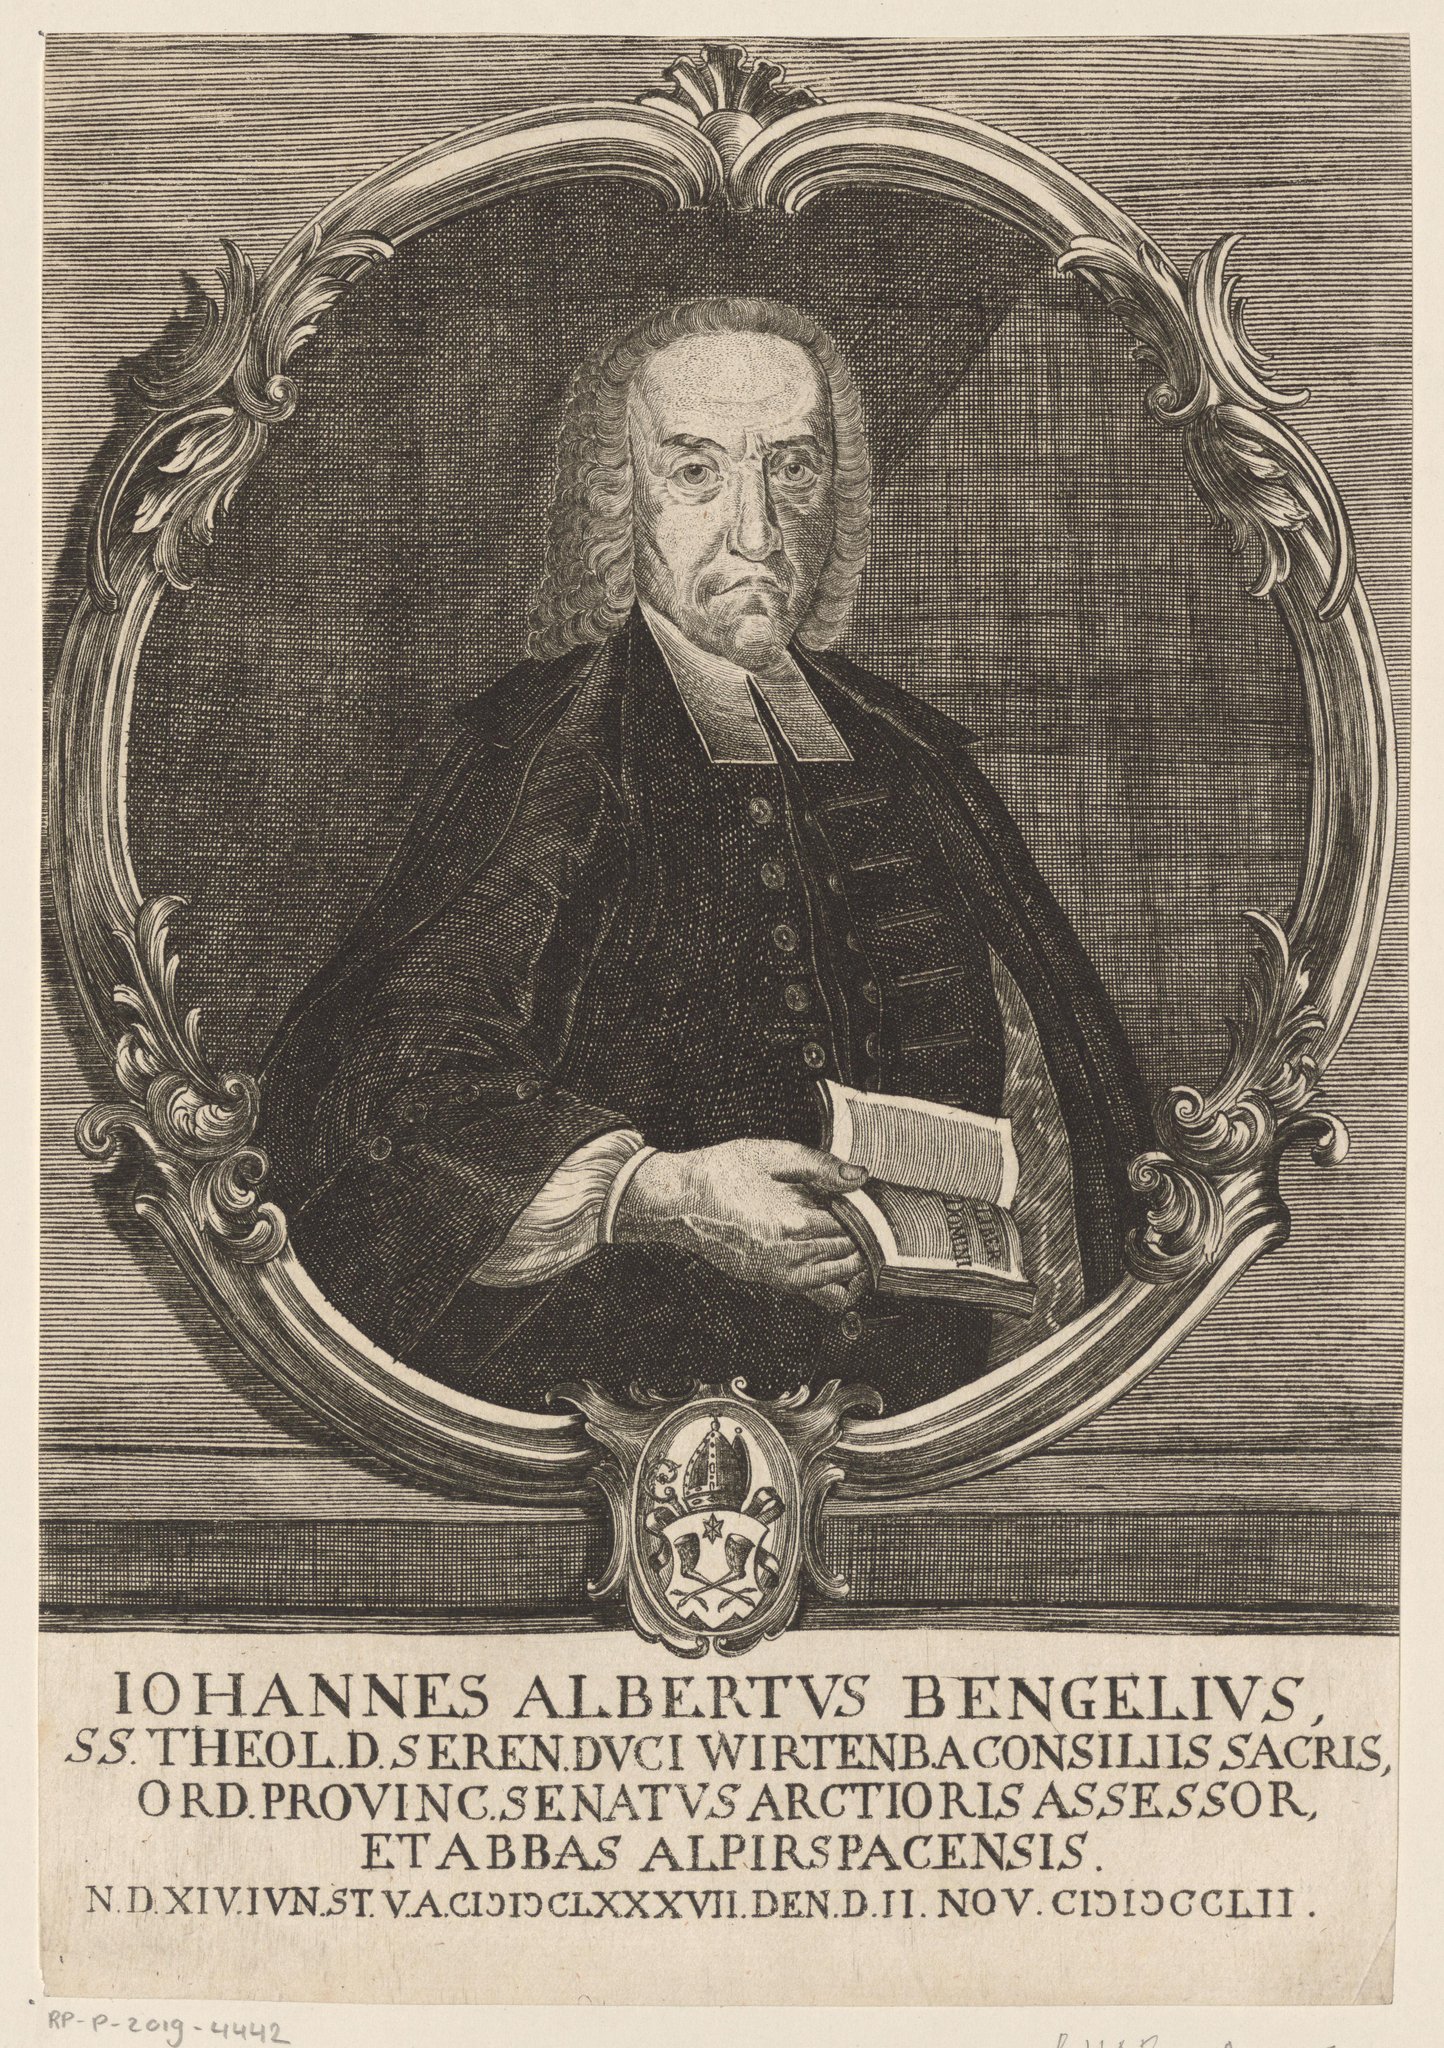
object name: print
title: Portret van Johann Albrecht Bengel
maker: Anonymous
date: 1752-1799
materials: paper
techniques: engraving, etching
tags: historical persons, book, armorial bearing, heraldry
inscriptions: collector's mark: Lugt 2228